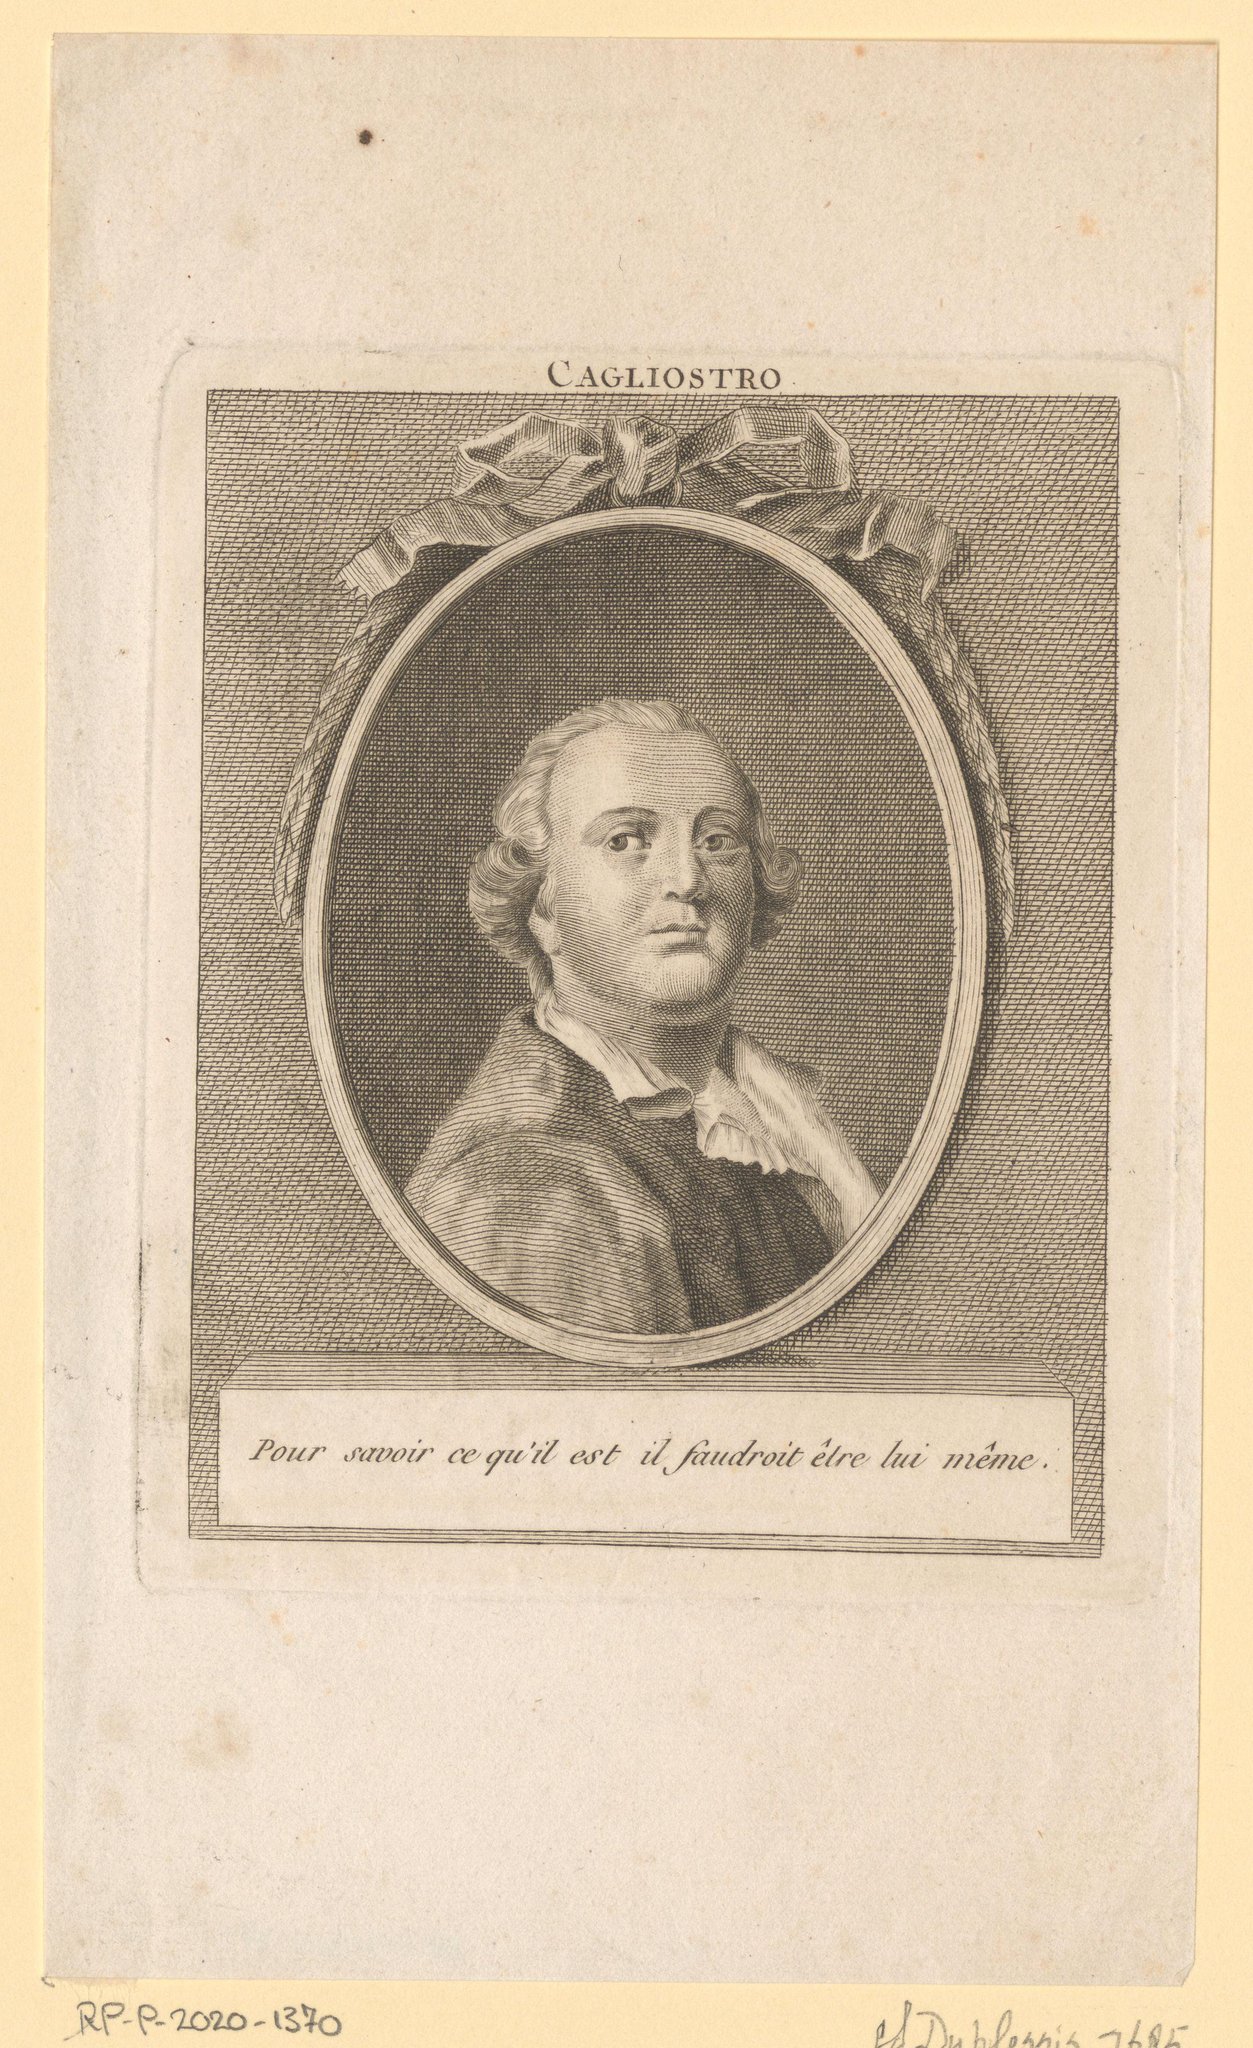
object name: print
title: Portret van Alessandro Cagliostro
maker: Anonymous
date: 1780-1820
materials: paper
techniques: engraving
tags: italy, historical persons